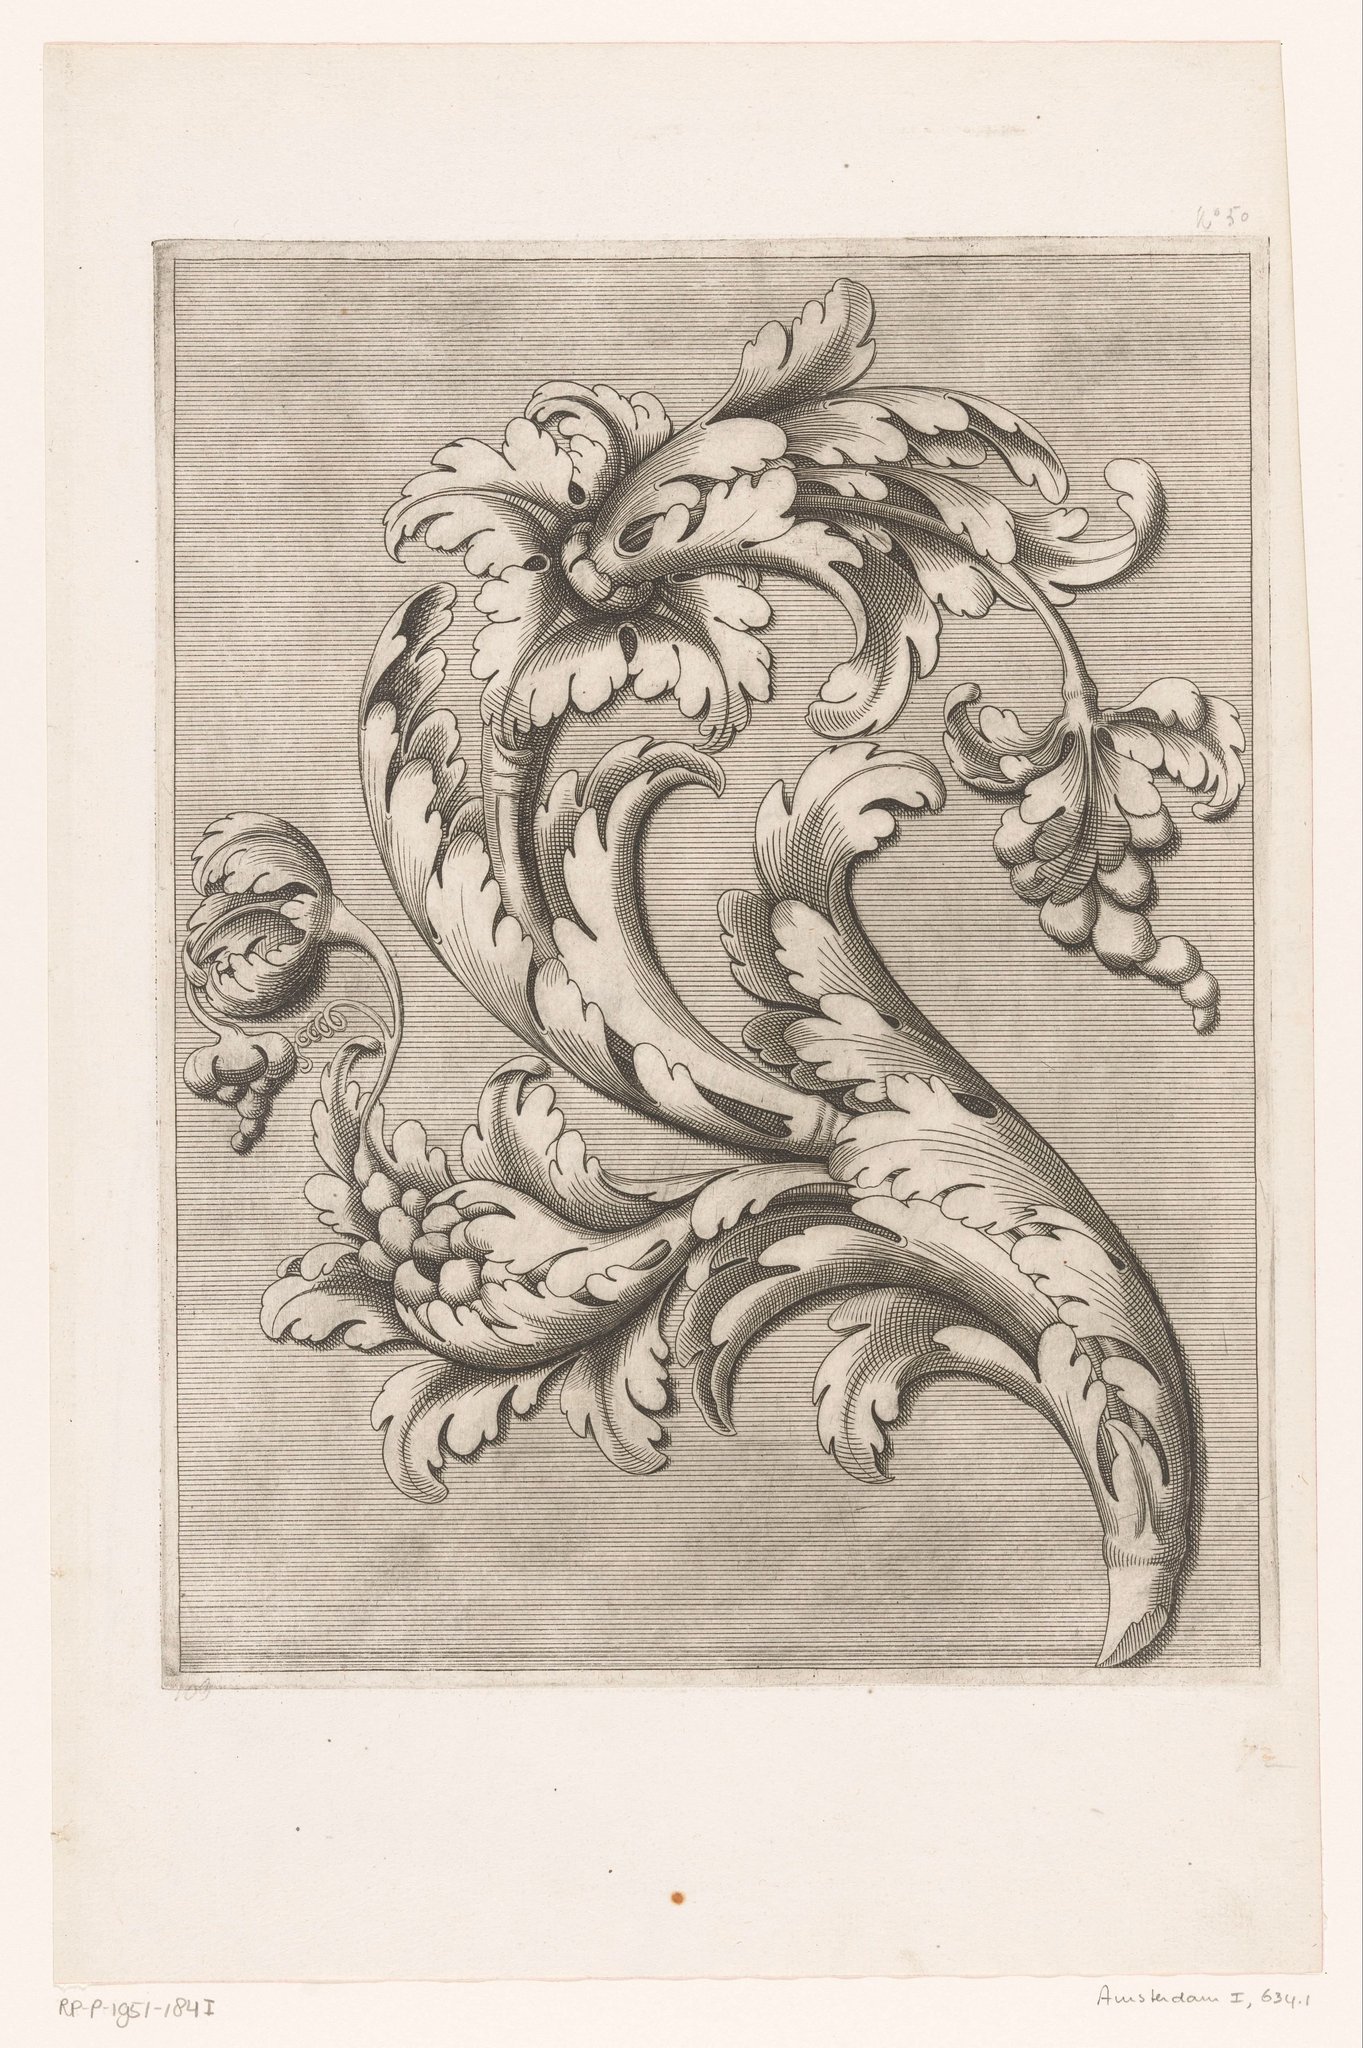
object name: print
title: Acanthusmotief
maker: cesare domenichi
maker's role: print maker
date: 1589-1614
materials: paper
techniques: engraving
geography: italy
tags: acanthus ~ ornament - aa - stylized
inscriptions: collector's mark: Lugt 2228